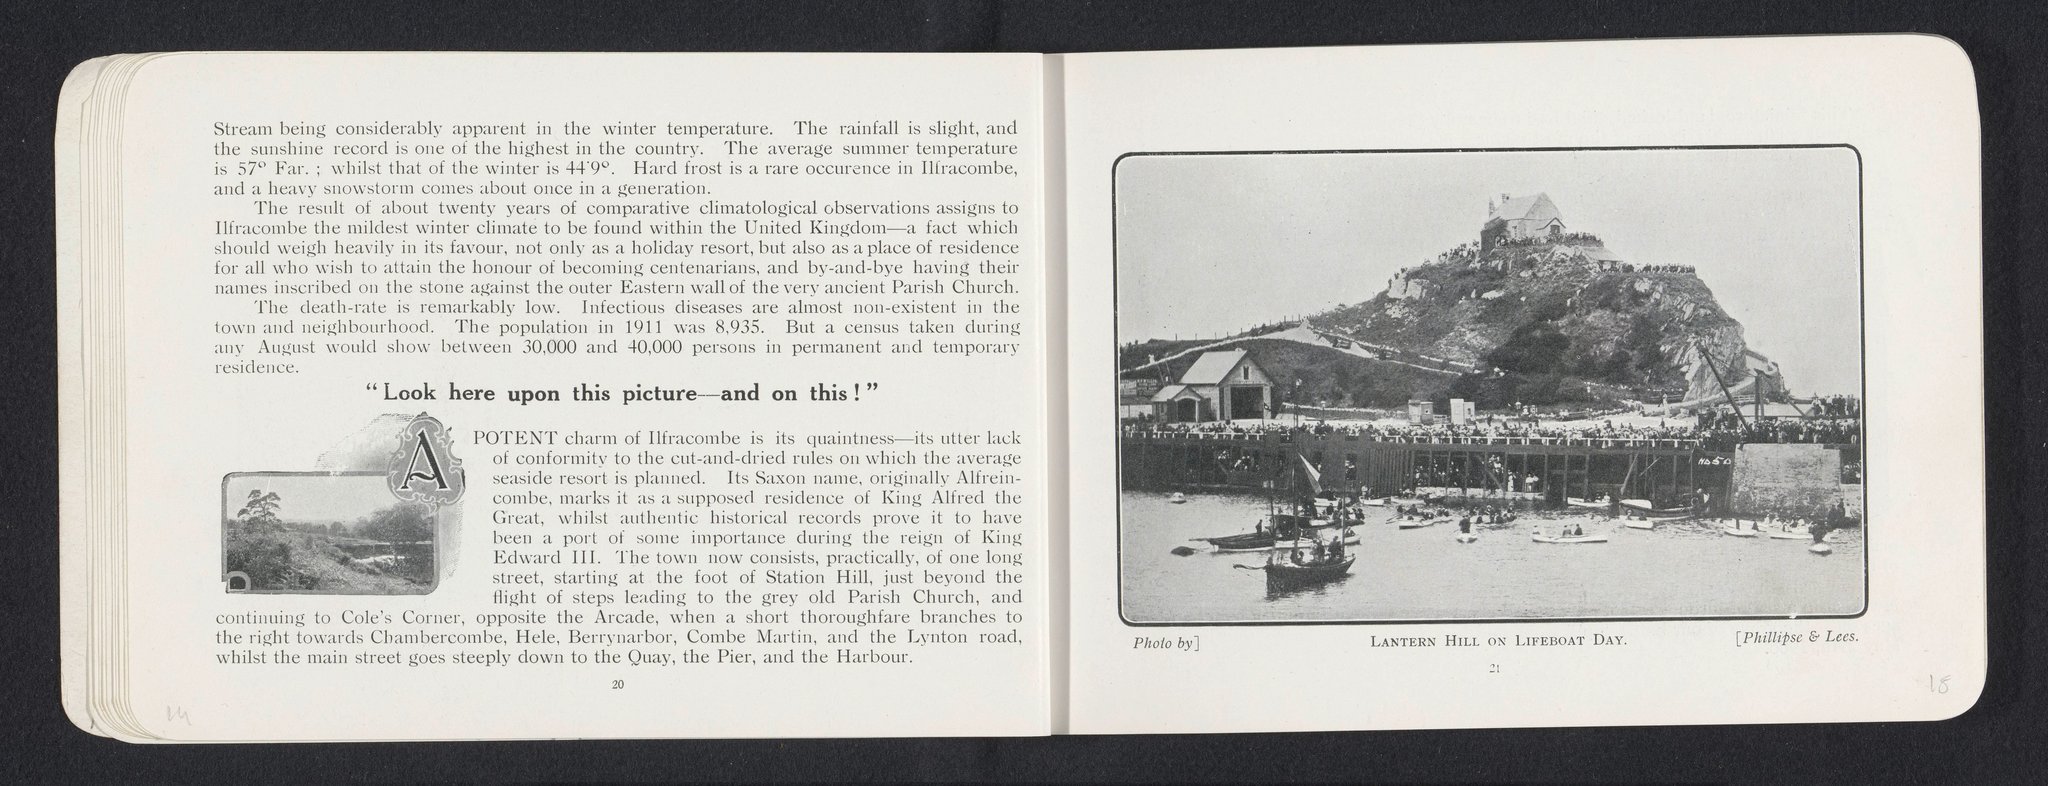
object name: photomechanical print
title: Weiland nabij Ilfracombe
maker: Anonymous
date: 1900-1920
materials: paper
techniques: autotype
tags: meadow, pasture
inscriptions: inscription: ‘Stream being (...) and the Harbour.’